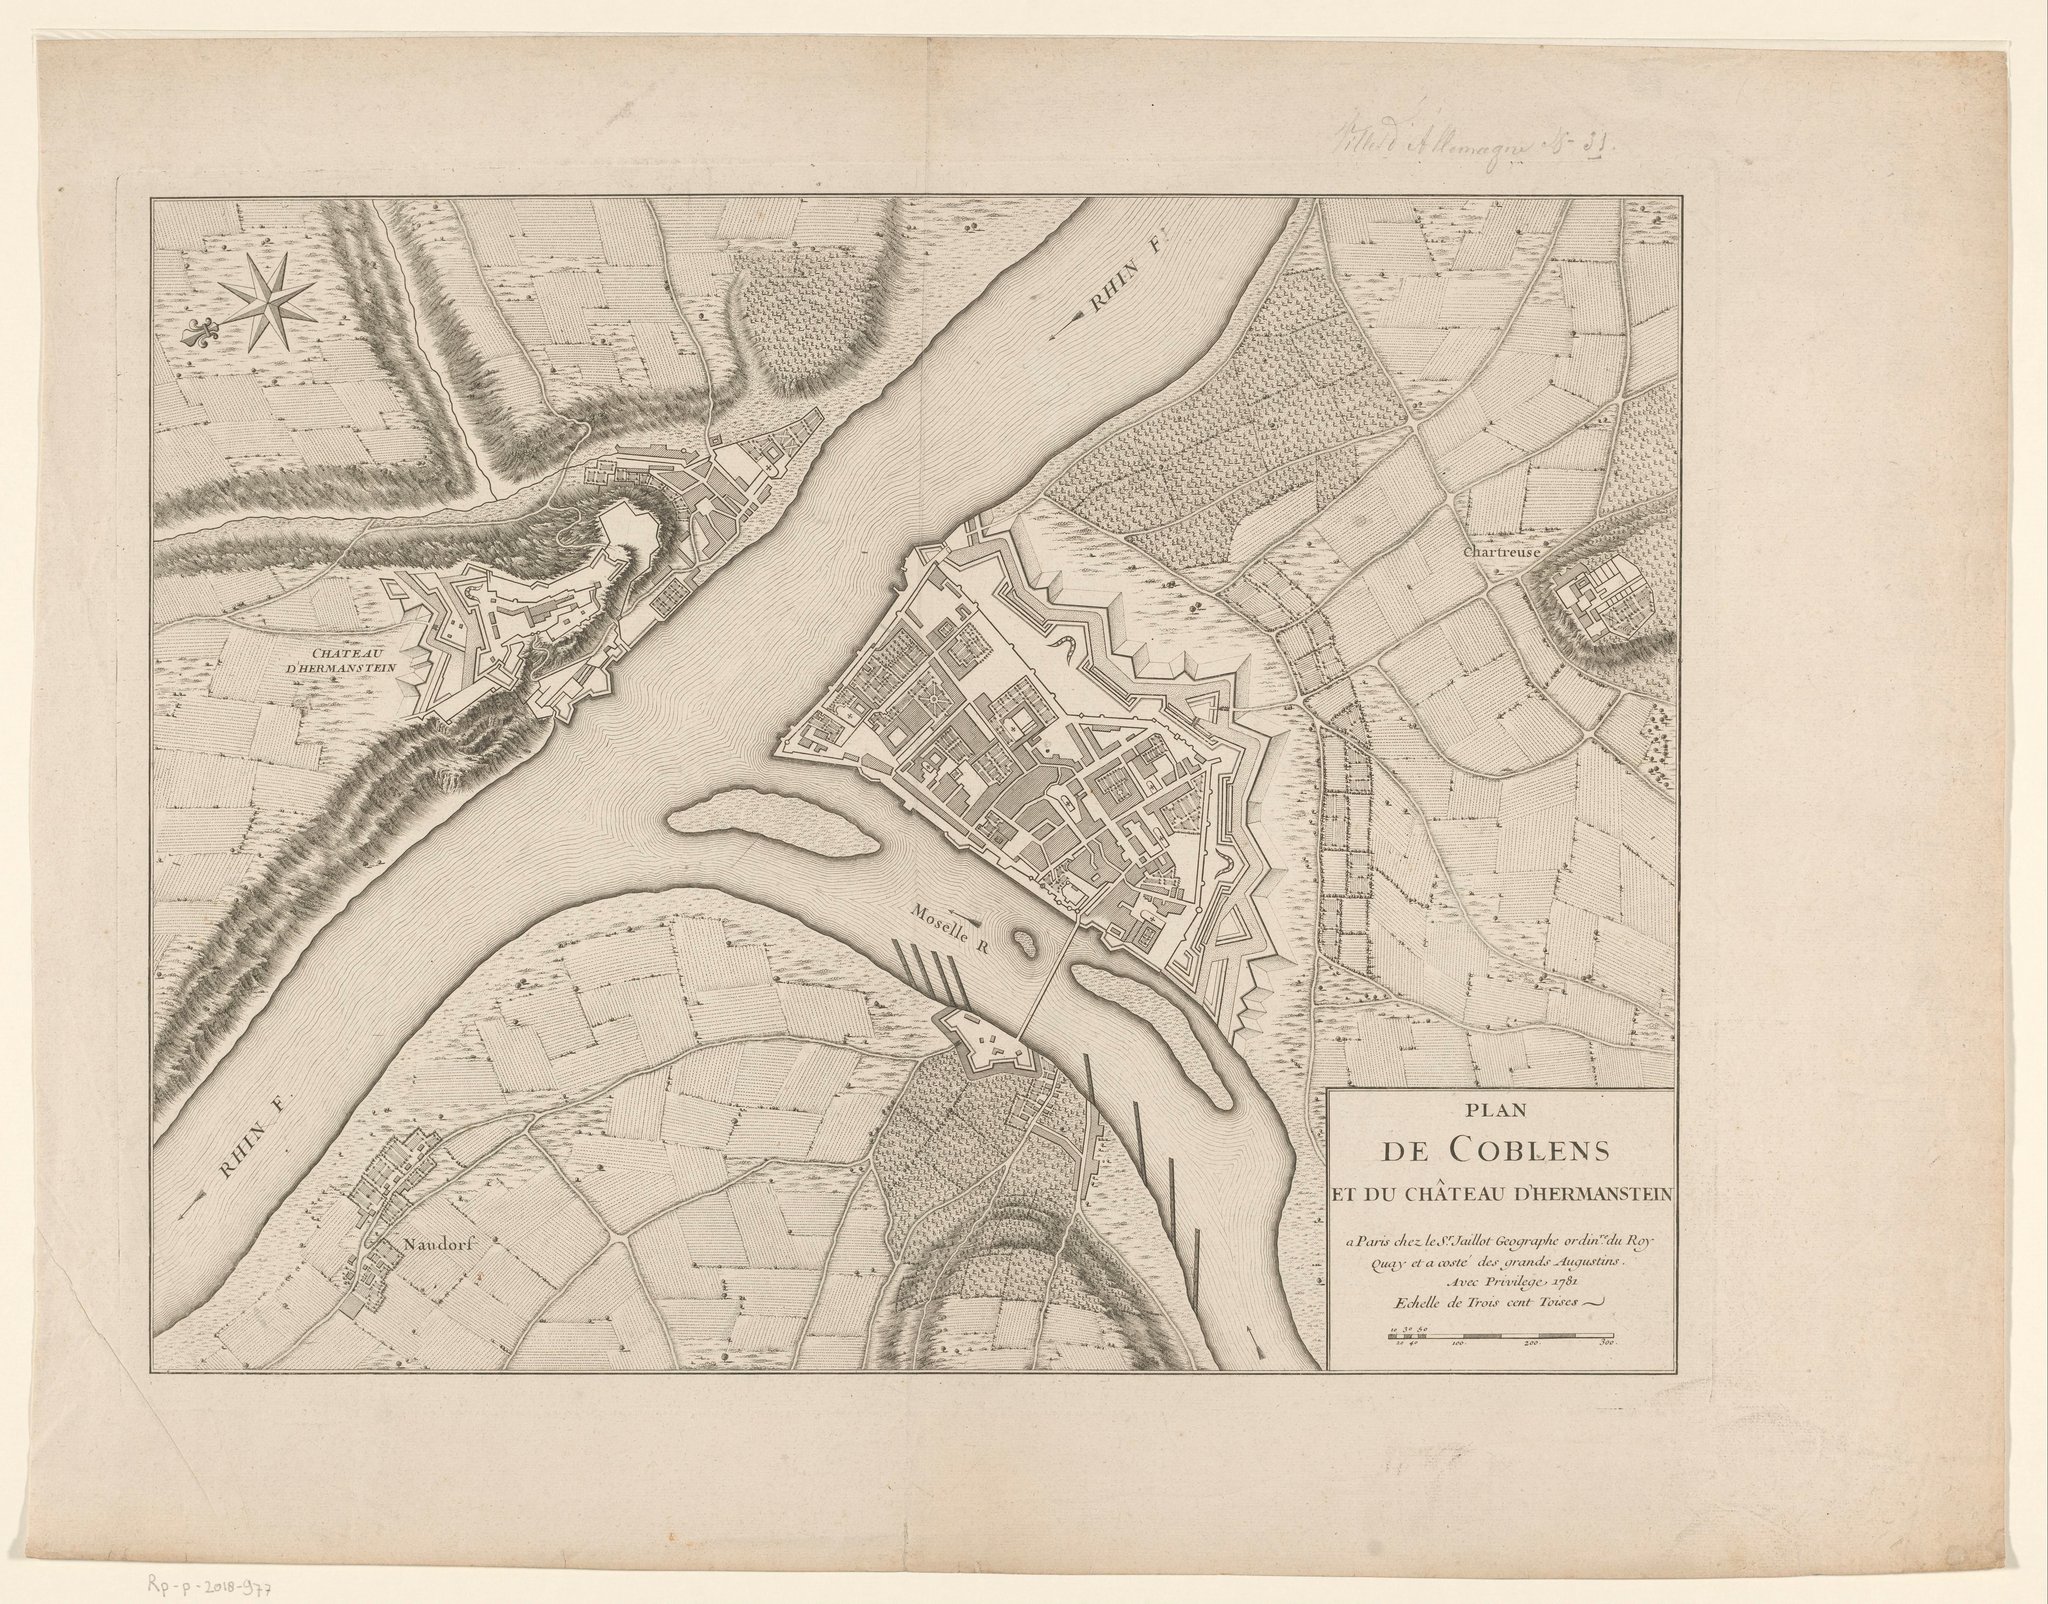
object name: print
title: Plan de Coblens et du château d'Hermanstein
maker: Anonymous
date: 1781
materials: paper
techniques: engraving, etching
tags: maps of cities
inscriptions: collector's mark: Lugt 2228